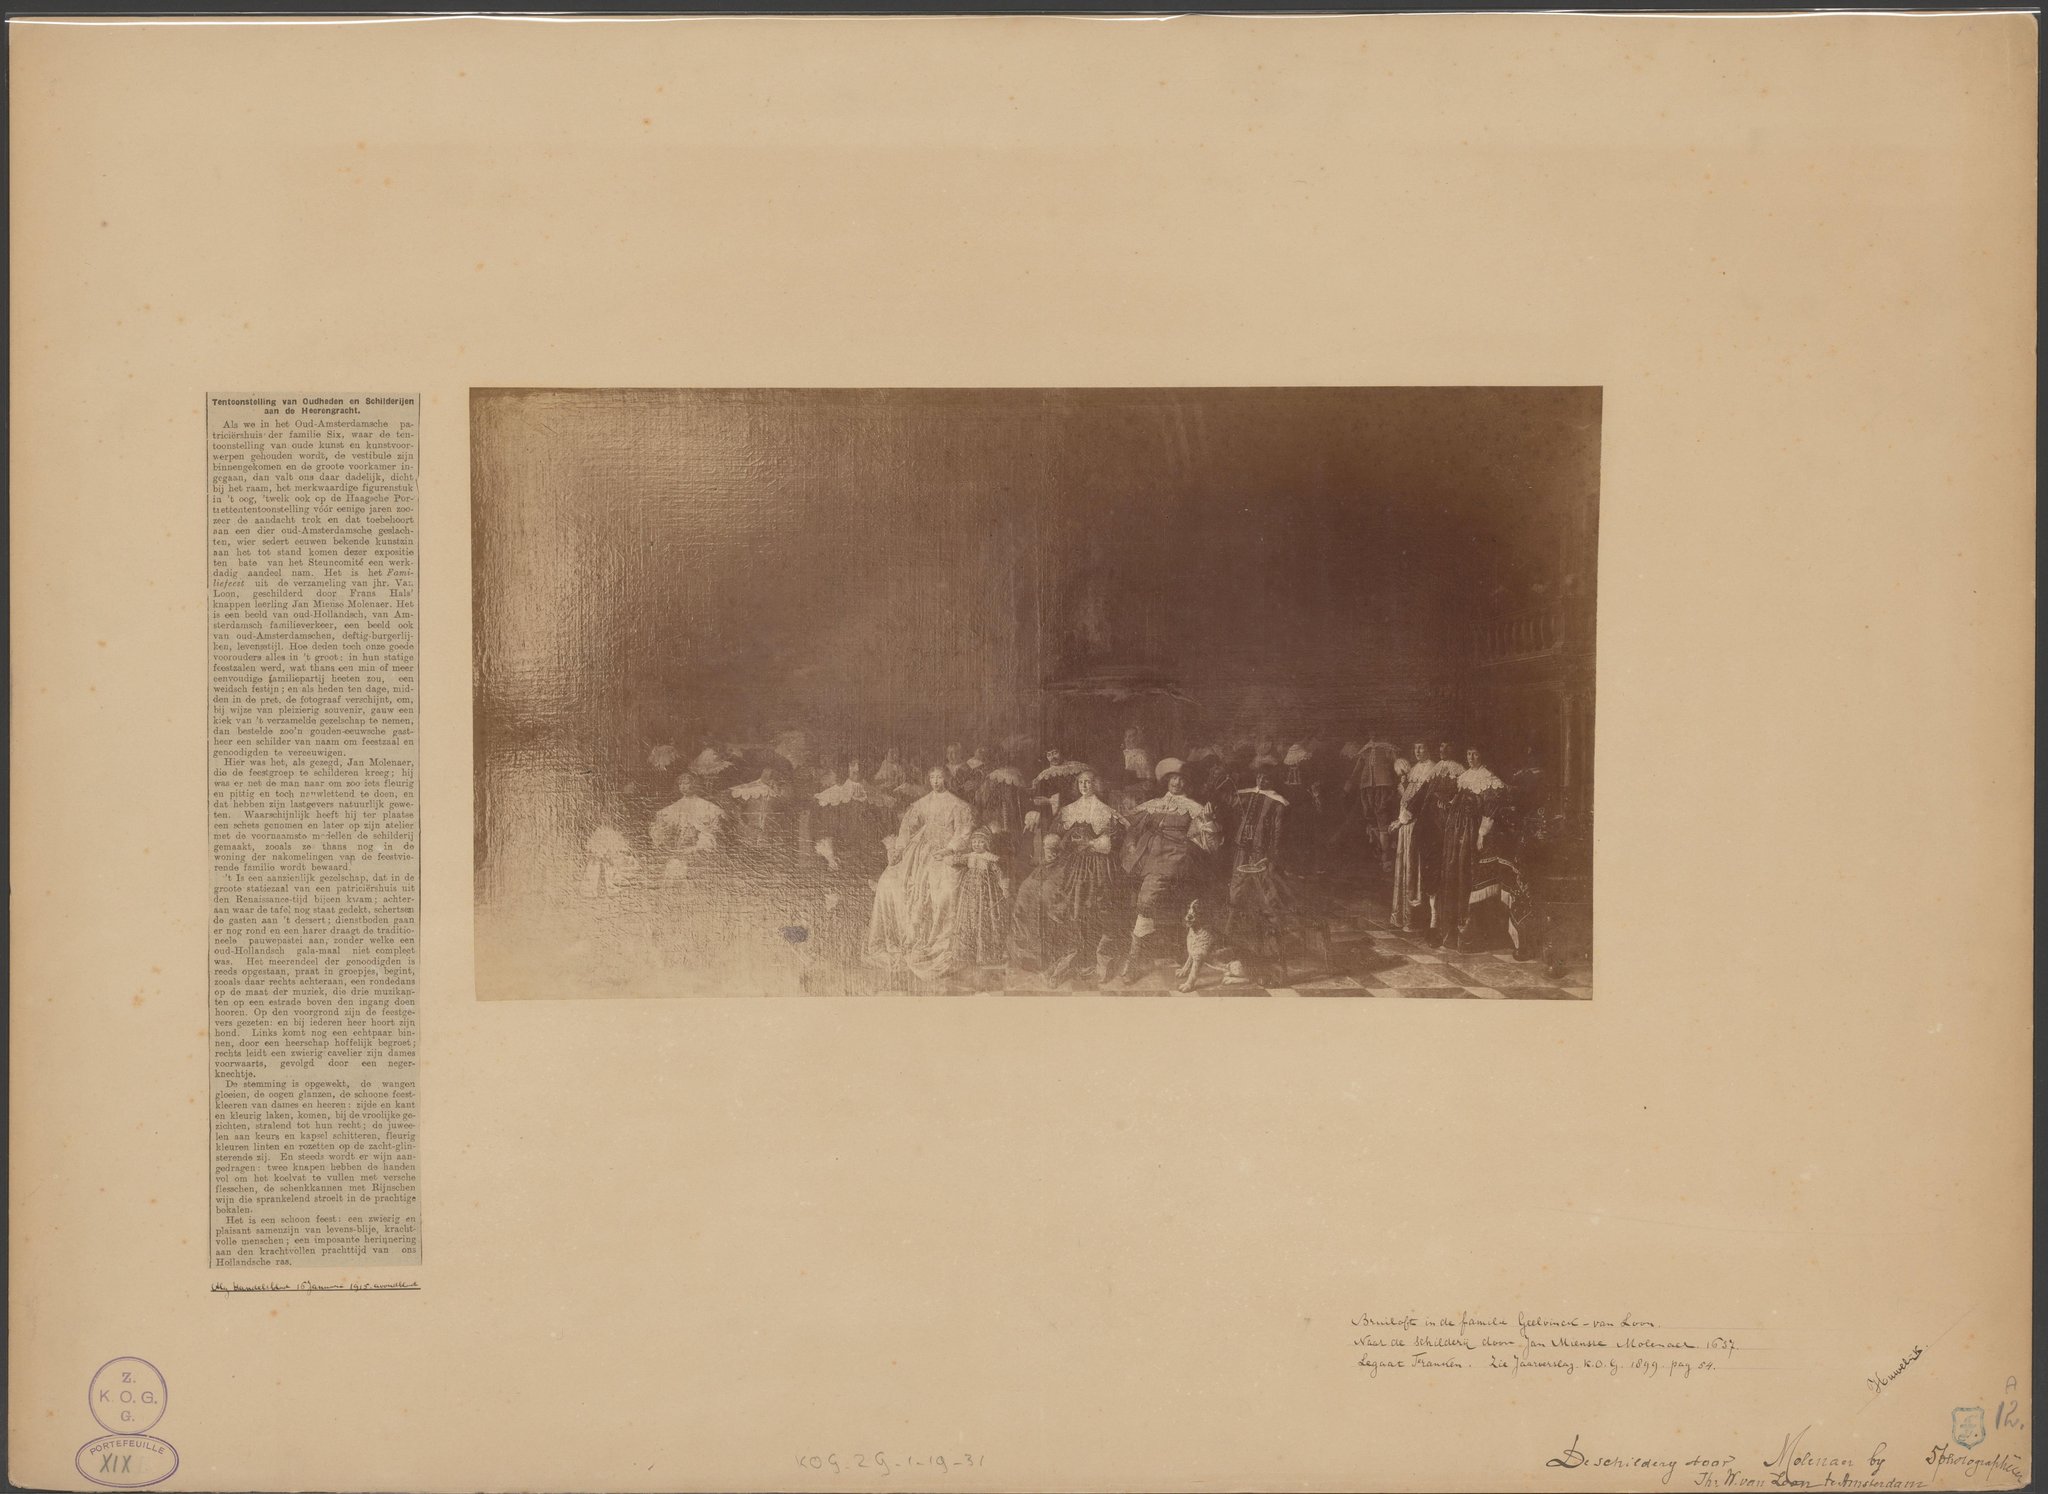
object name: newspaper clipping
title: Reproductie van het schilderij 'Bruiloft van Willem van Loon en Margaretha Bas' door Jan Miense Molenaar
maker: Anonymous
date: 1850-1899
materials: paper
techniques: albumen print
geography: amsterdam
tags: wedding feast, wedding meal, picture, painting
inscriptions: collector's mark:, collector's mark: Lugt 1641, collector's mark: Lugt 963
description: Reproductie van het schilderij 'Bruiloft van Willem van Loon en Margaretha Bas' door Jan Miense Molenaar (1637). Naast de foto een krantenknipsel uit 1915 over tentoonstelling van het schilderij. Onderwerpsrubrieken binnen de Atlas Zeden en Gewoonten: Des Menschen Begin, Midden en Einde. Bruiloft en huwelijk.